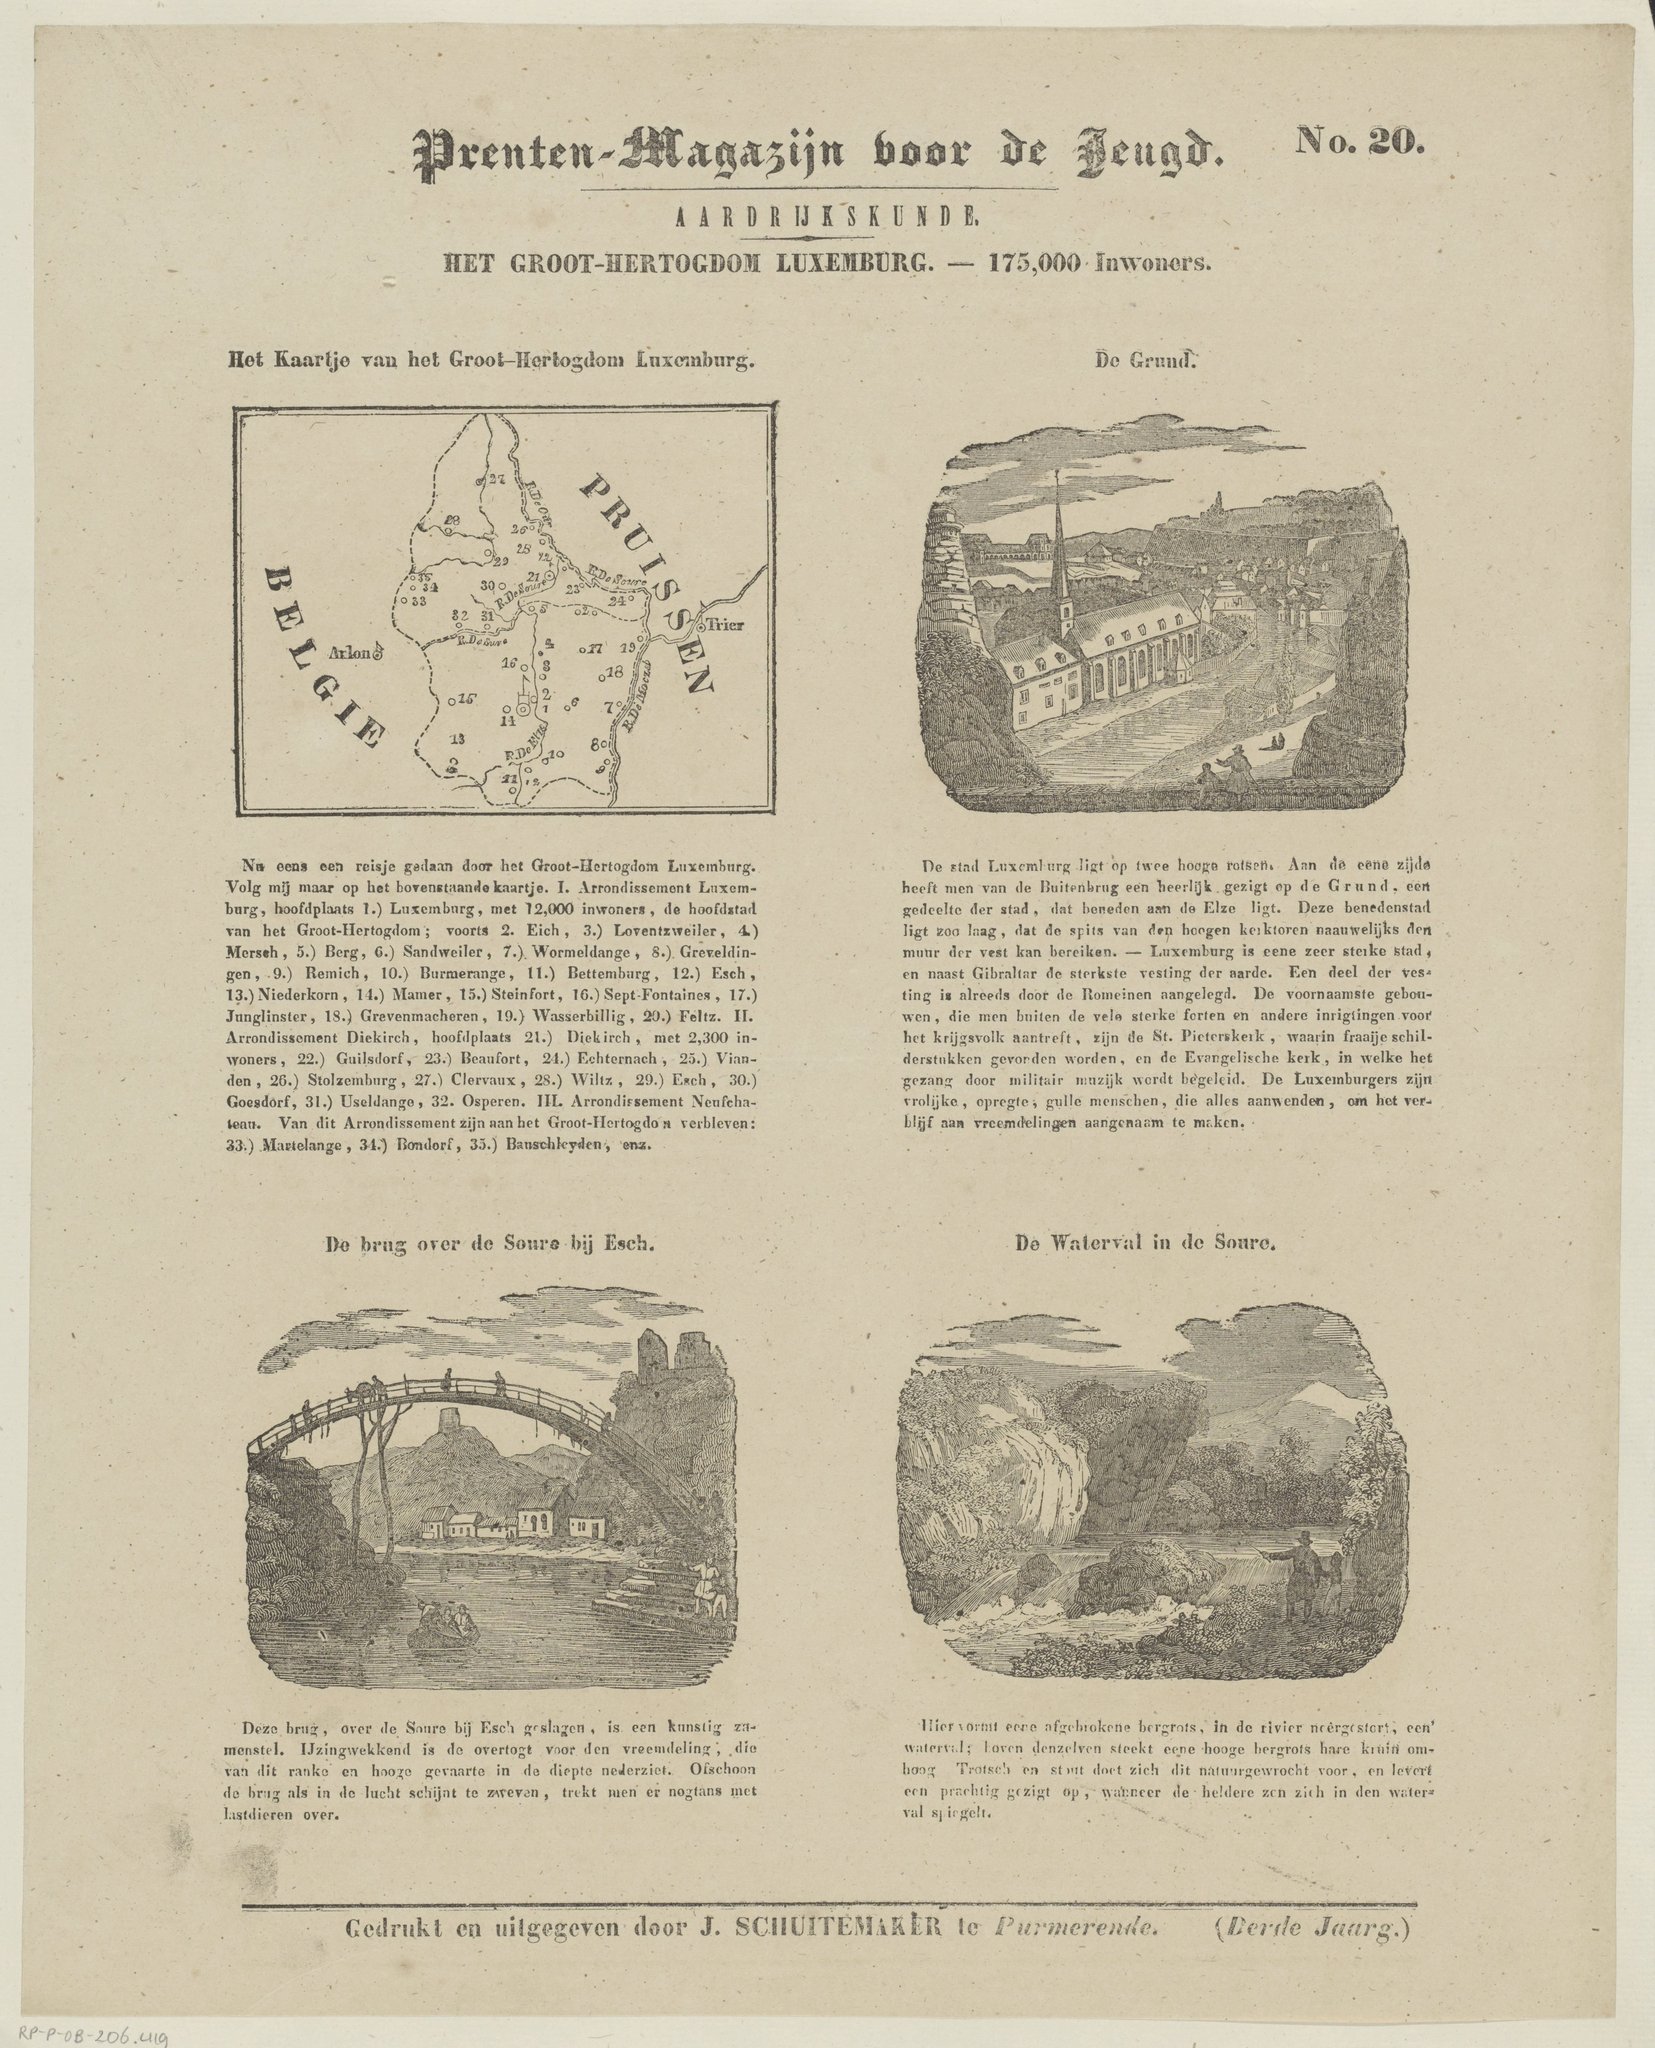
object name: popular print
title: Het groot-hertogdom Luxemburg. - 175,000 inwoners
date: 1844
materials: paper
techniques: letterpress printing, engraving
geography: netherlands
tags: maps, atlases, bridge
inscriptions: collector's mark: Lugt 2760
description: Blad met 4 voorstellingen over het groot-hertogdom Luxemburg met een kaart en belangrijke plaatsen: Grund, de brug over de Sûre en de waterval in de Sûre. Boven elke voorstelling een titel en onder elke voorstelling een onderschrift. Genummerd rechtsboven: No. 20.